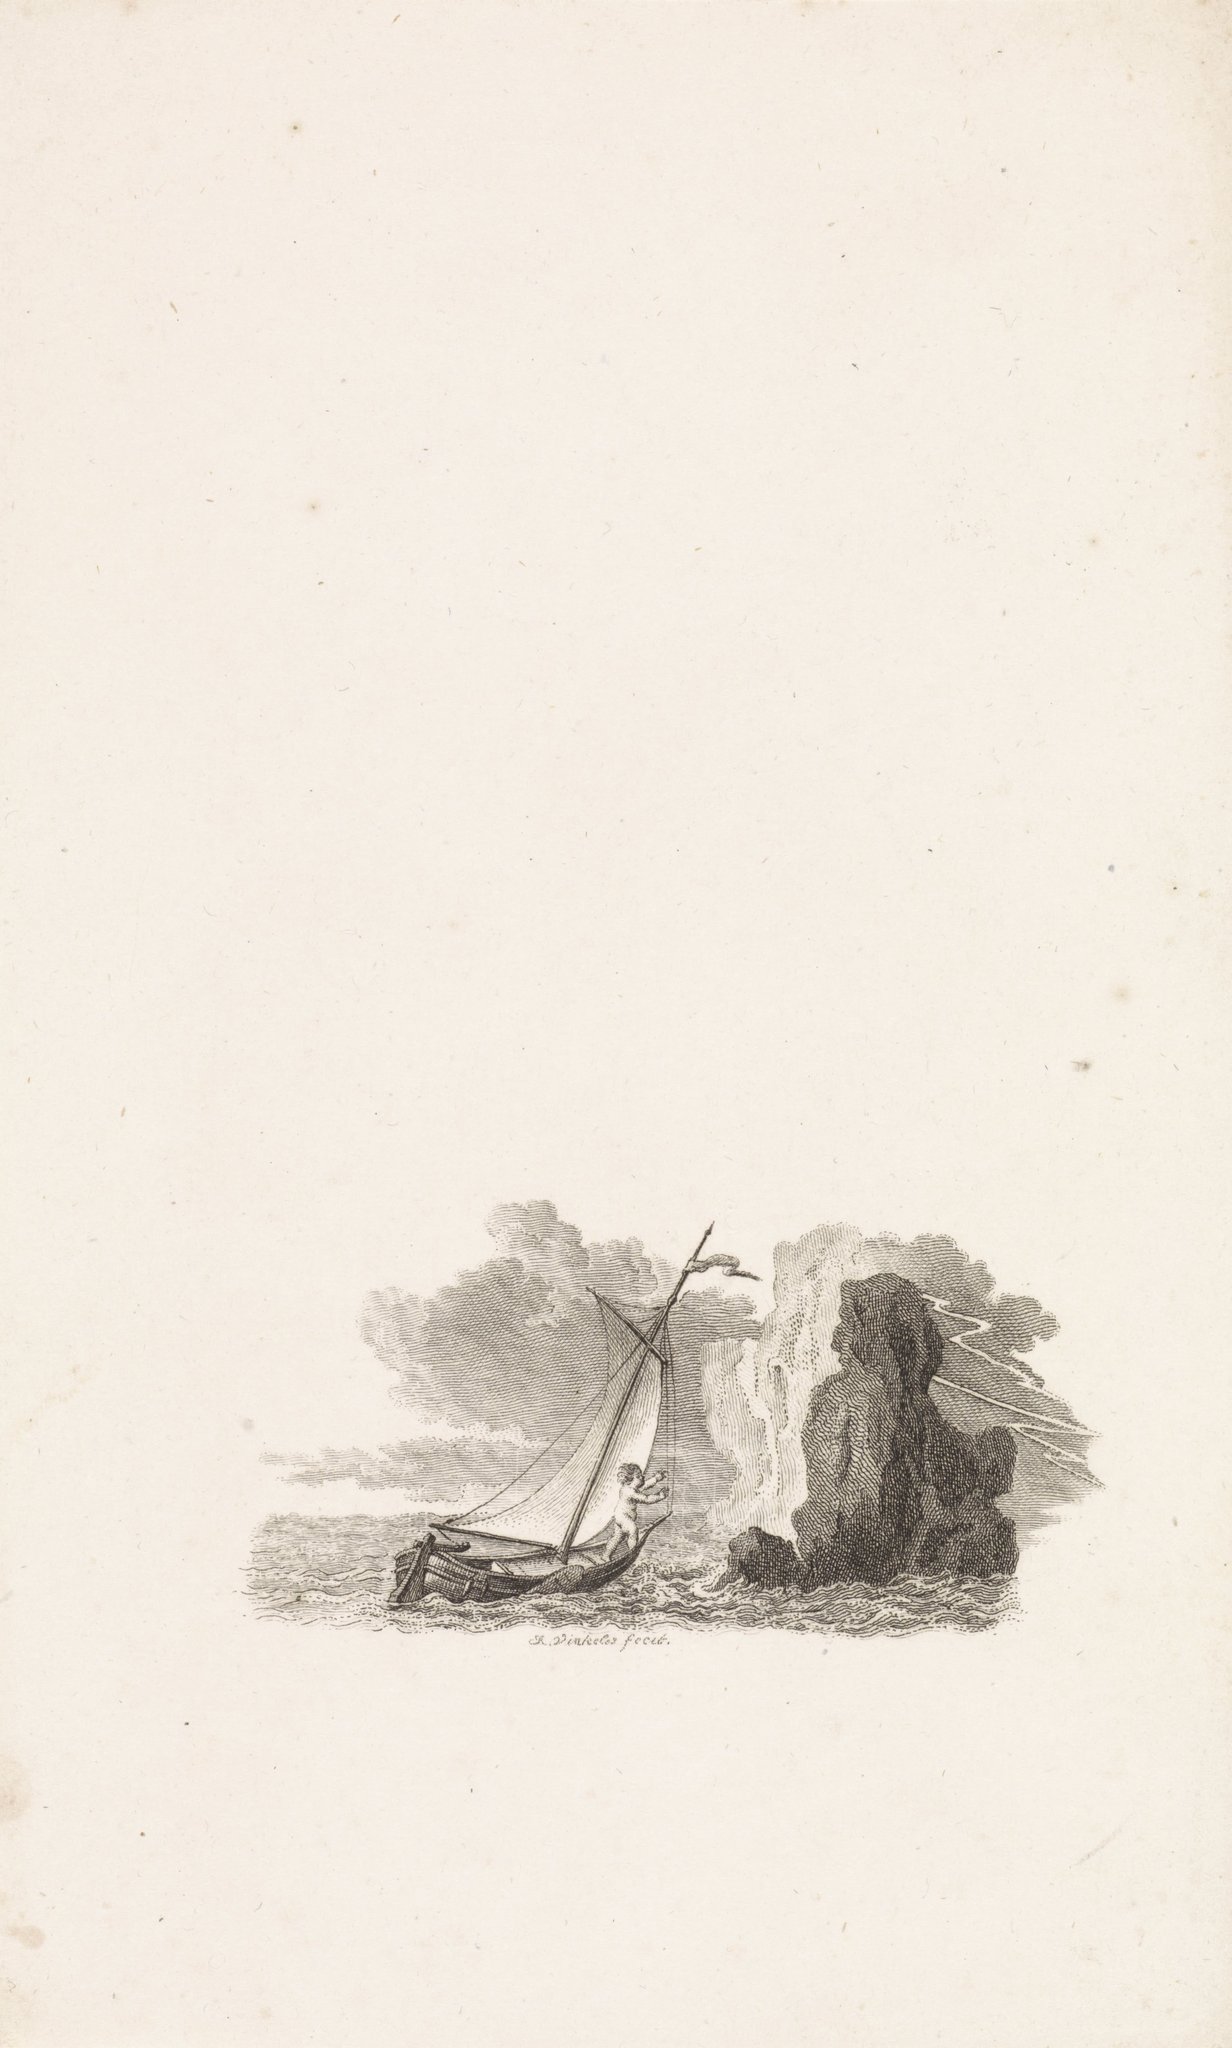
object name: print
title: Titelpagina voor: Rhijnvis Feith 'Ferdinand en Constantia, dl.1', 1785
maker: reinier vinkeles (i)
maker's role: draughtsman, print maker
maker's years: 1741-1816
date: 1785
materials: paper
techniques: engraving, etching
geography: amsterdam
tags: sailing-ship, sailing-boat, rowing-boat, canoe, etc., lightning, flash of lightning, thunderbolt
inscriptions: collector's mark: Lugt 2228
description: Proefdruk van titelpagina voor: Feith, Rhijnvis. Ferdinand en Constantia, dl. 1. Amsterdam: Johannes Allart, 1785.